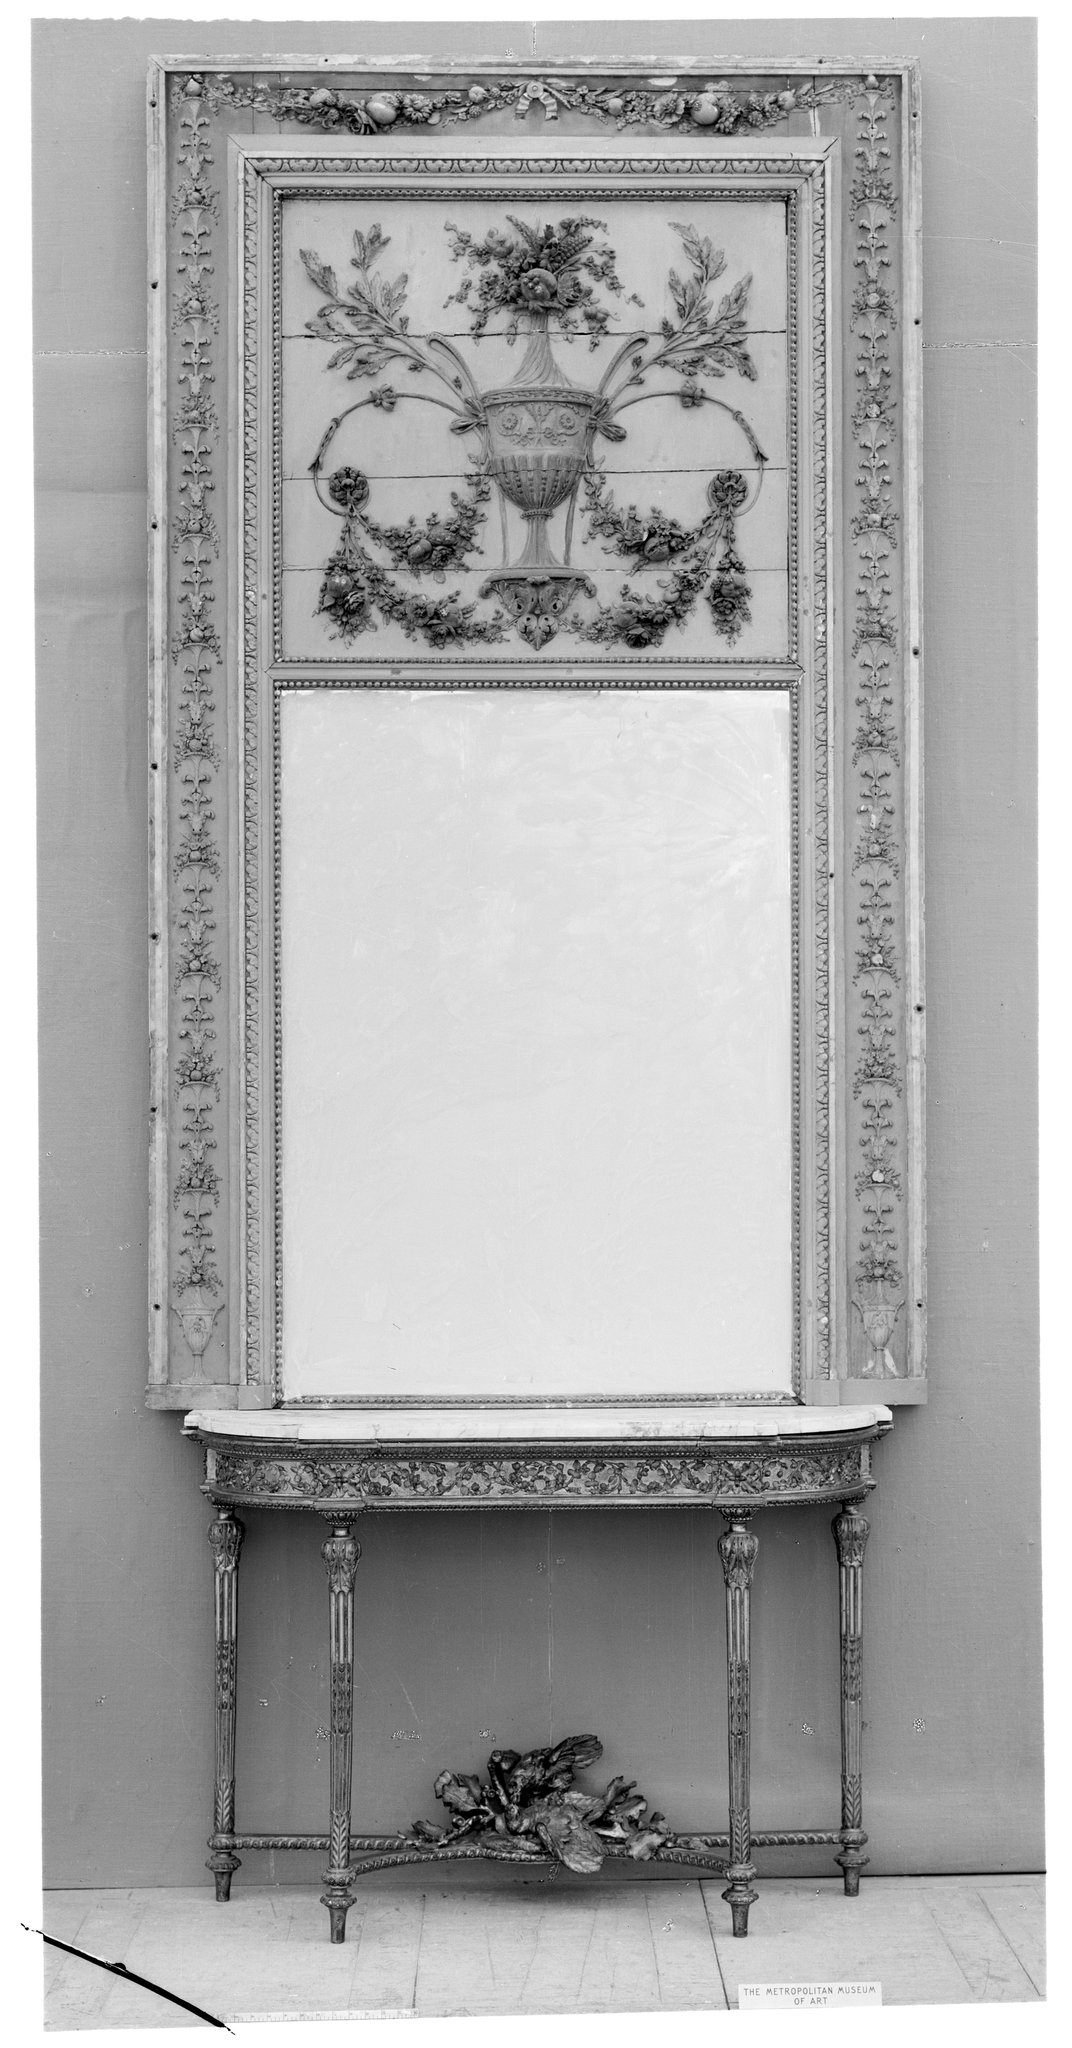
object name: pier glass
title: Pier glass (overmantel)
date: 1770-1790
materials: gilt, wood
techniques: painting